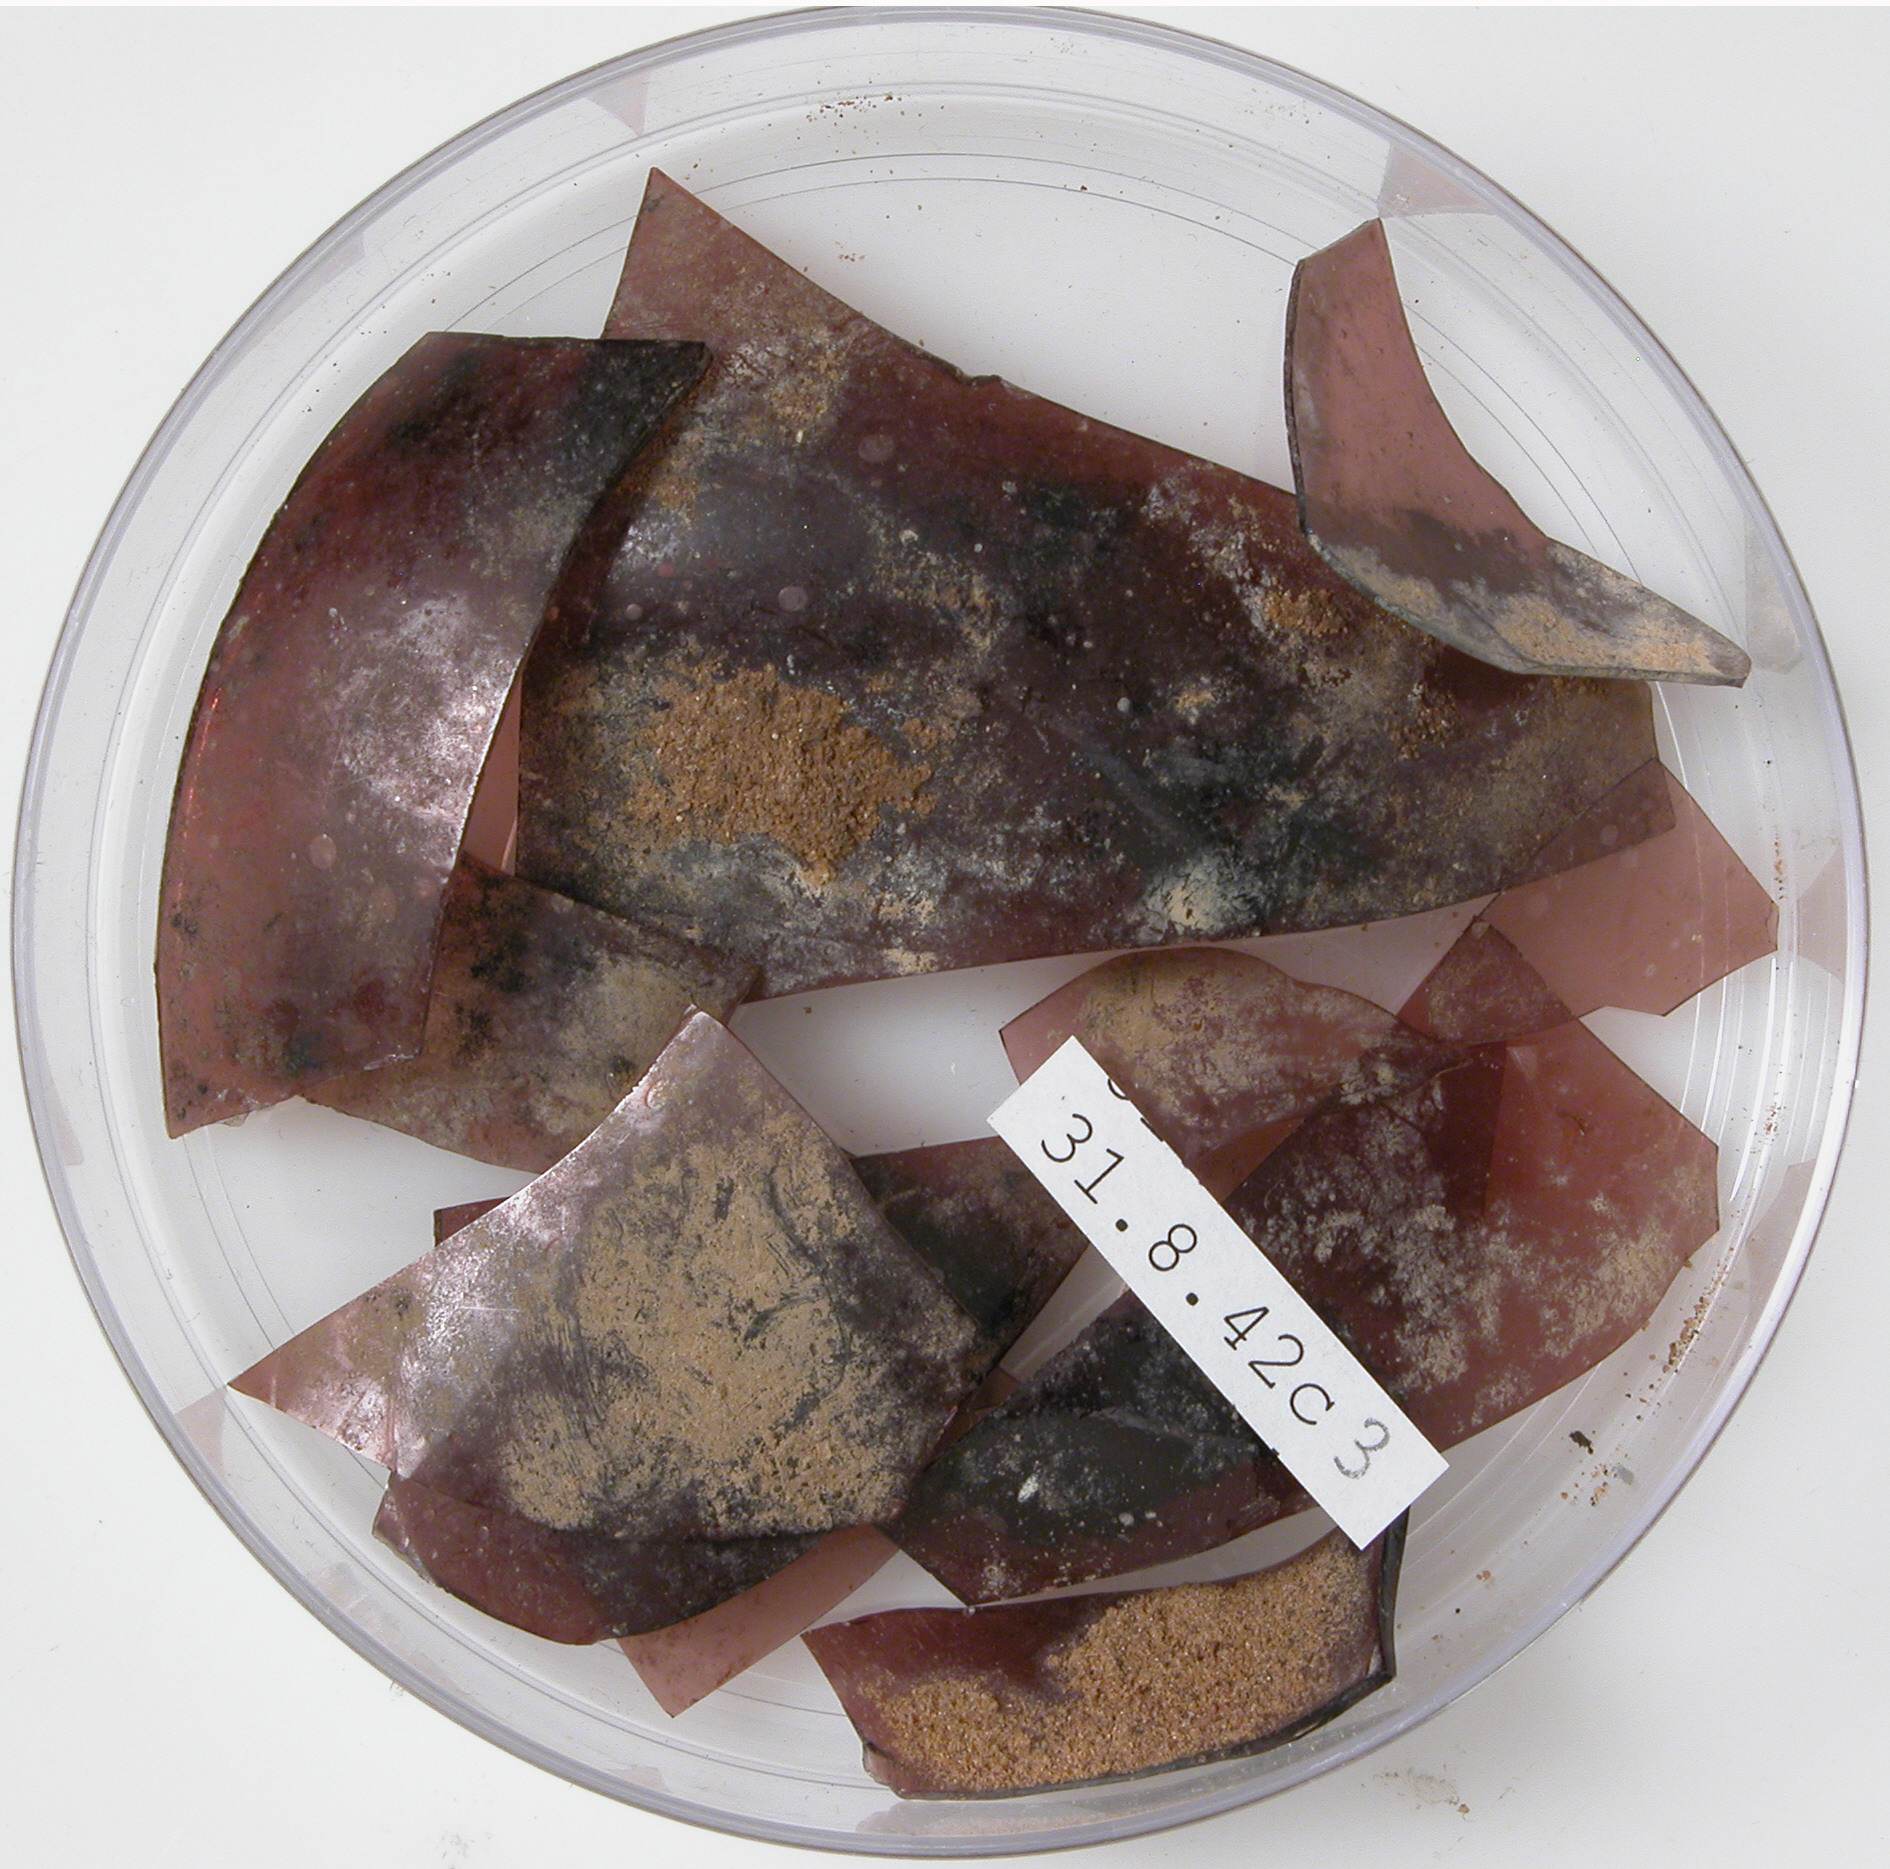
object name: fragment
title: Glass Fragments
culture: coptic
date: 301-400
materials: glass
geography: egypt